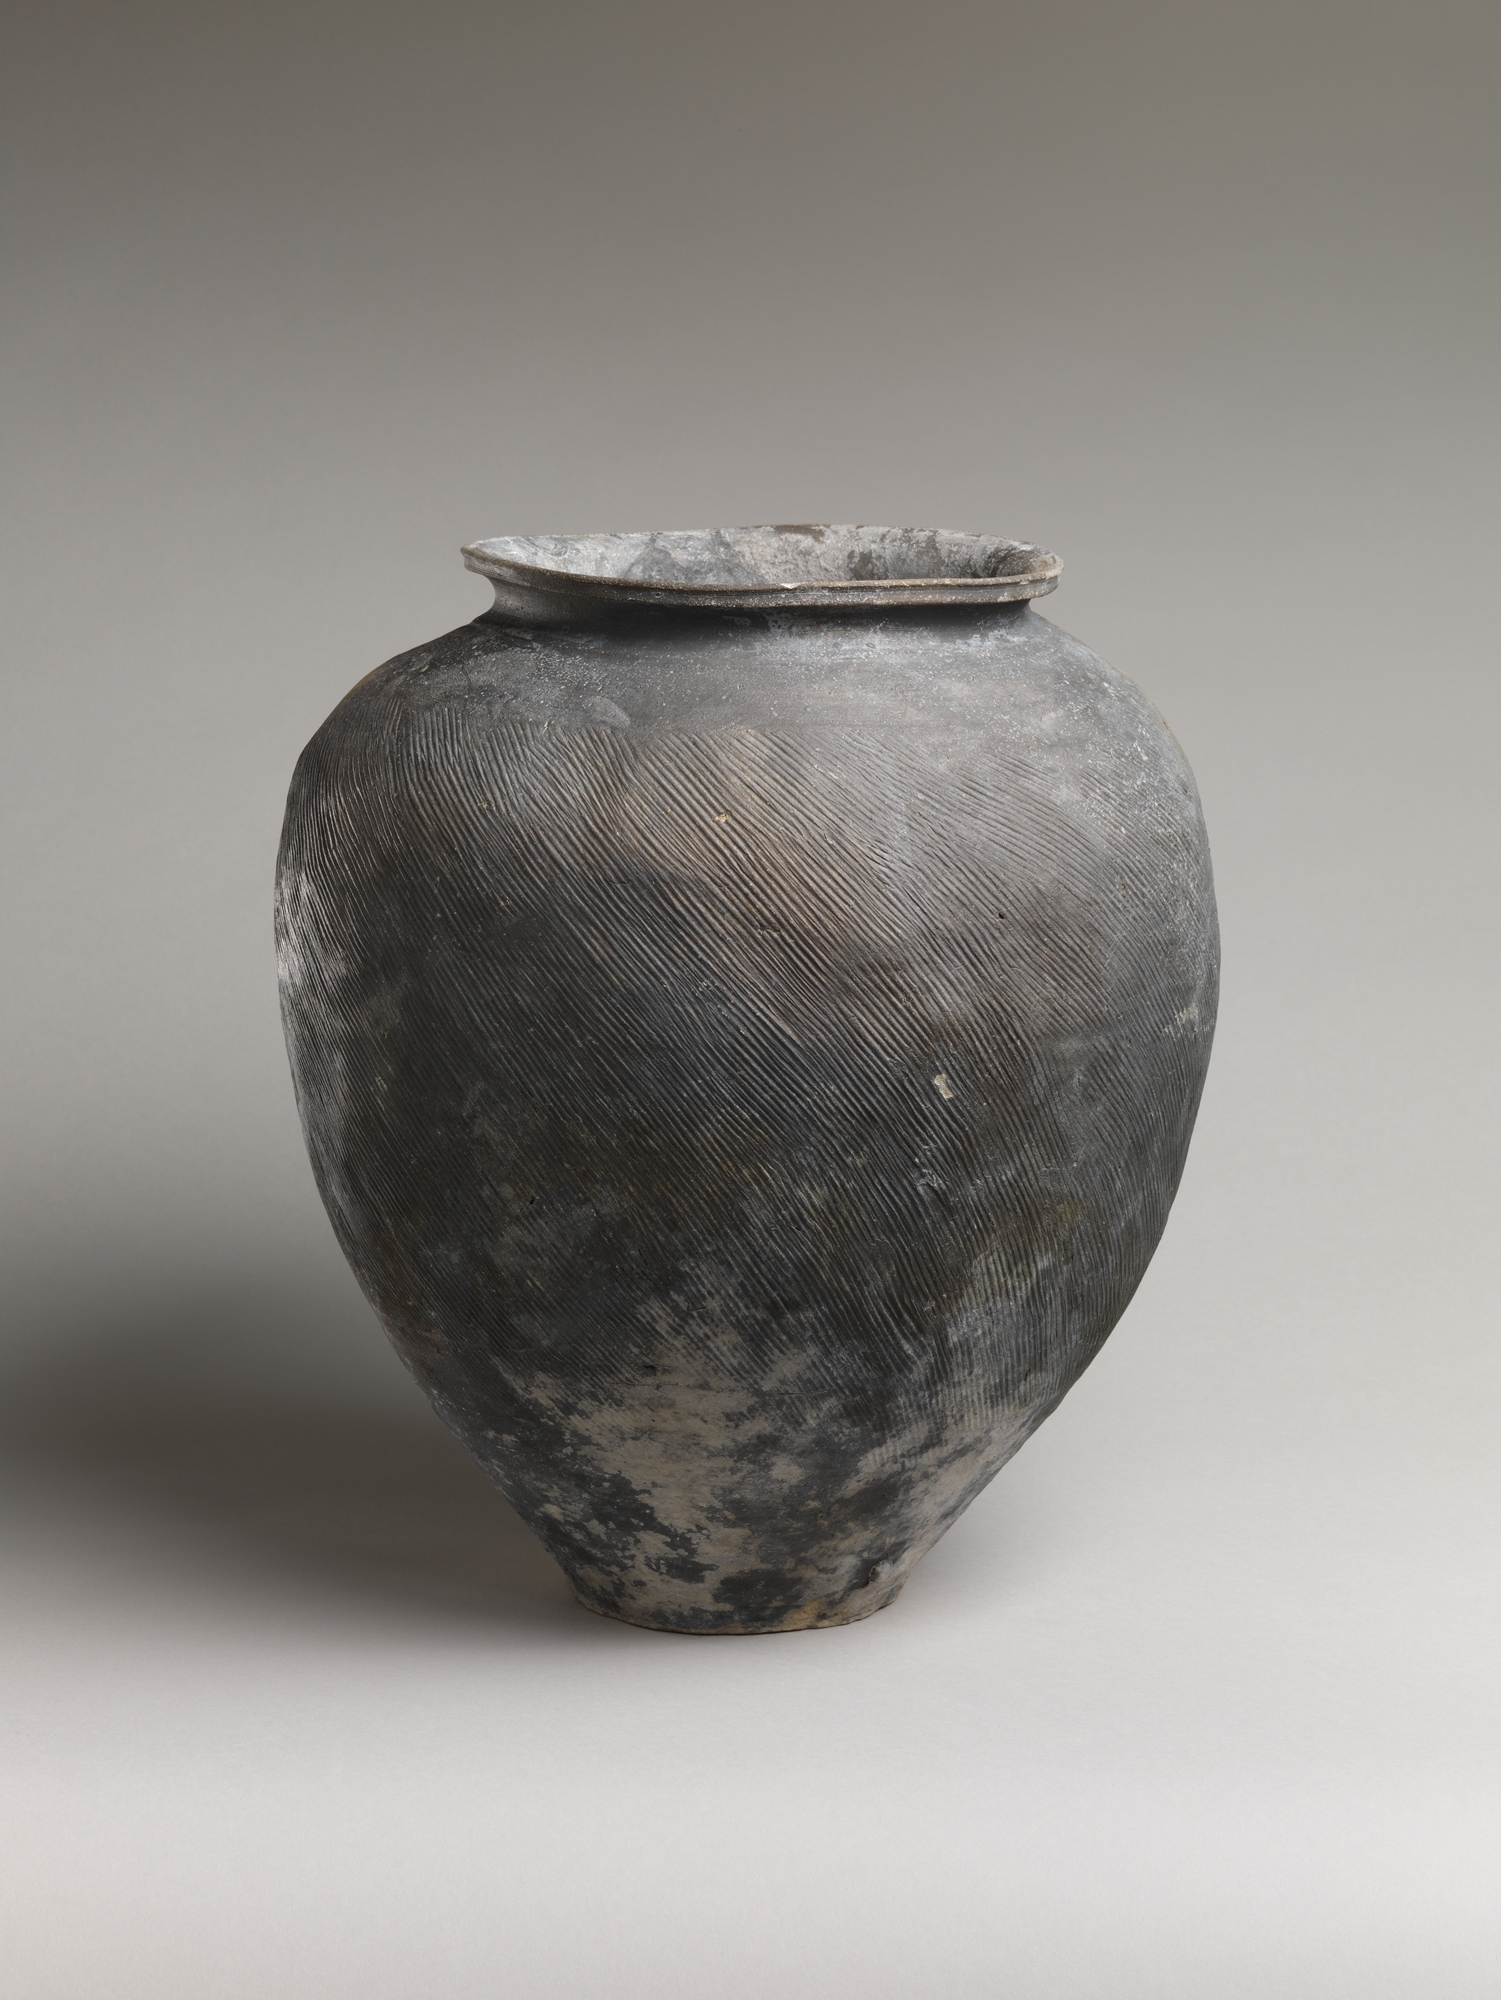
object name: jar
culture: japanese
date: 1151-1200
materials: earthenware